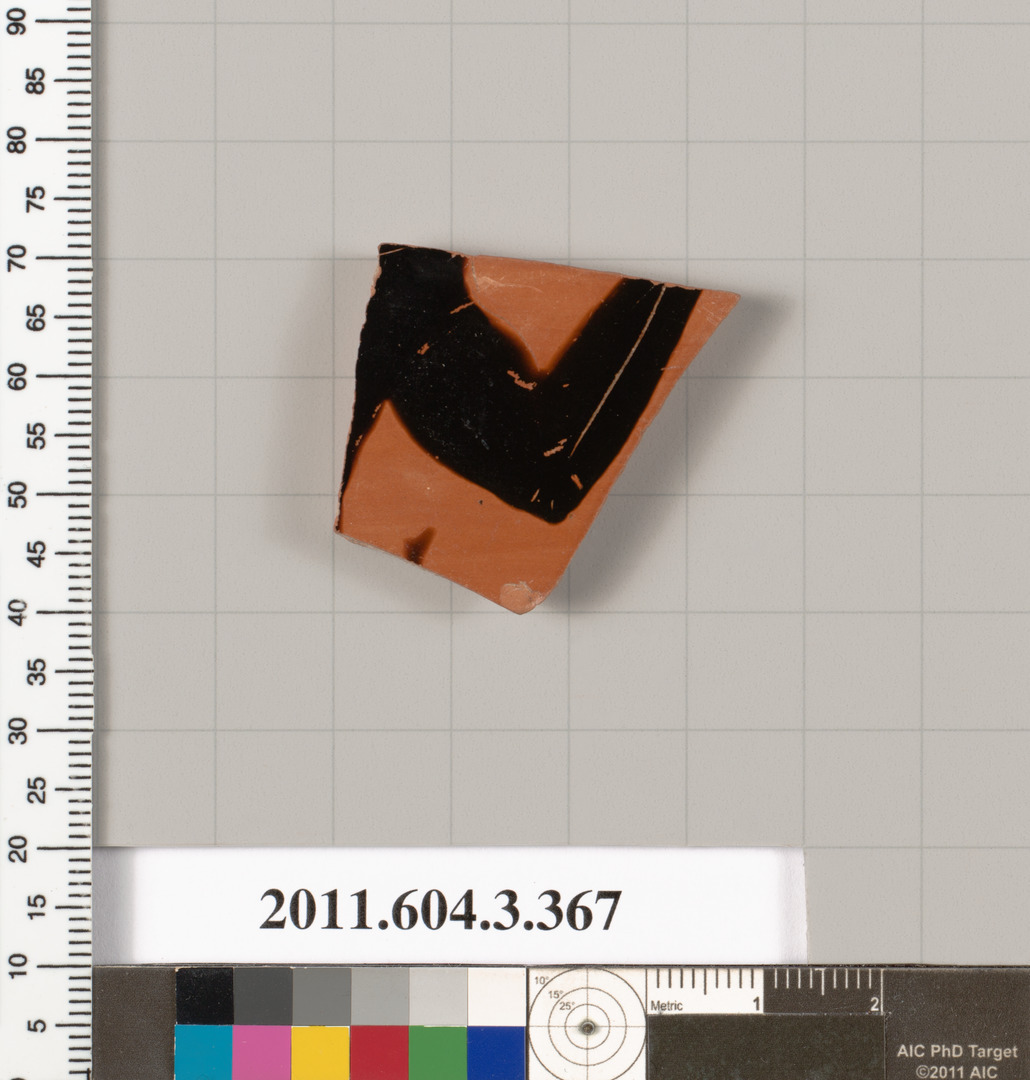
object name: neck amphora fragment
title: Terracotta fragment of a neck-amphora (jar)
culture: greek, attic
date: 534-501 BCE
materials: terracotta